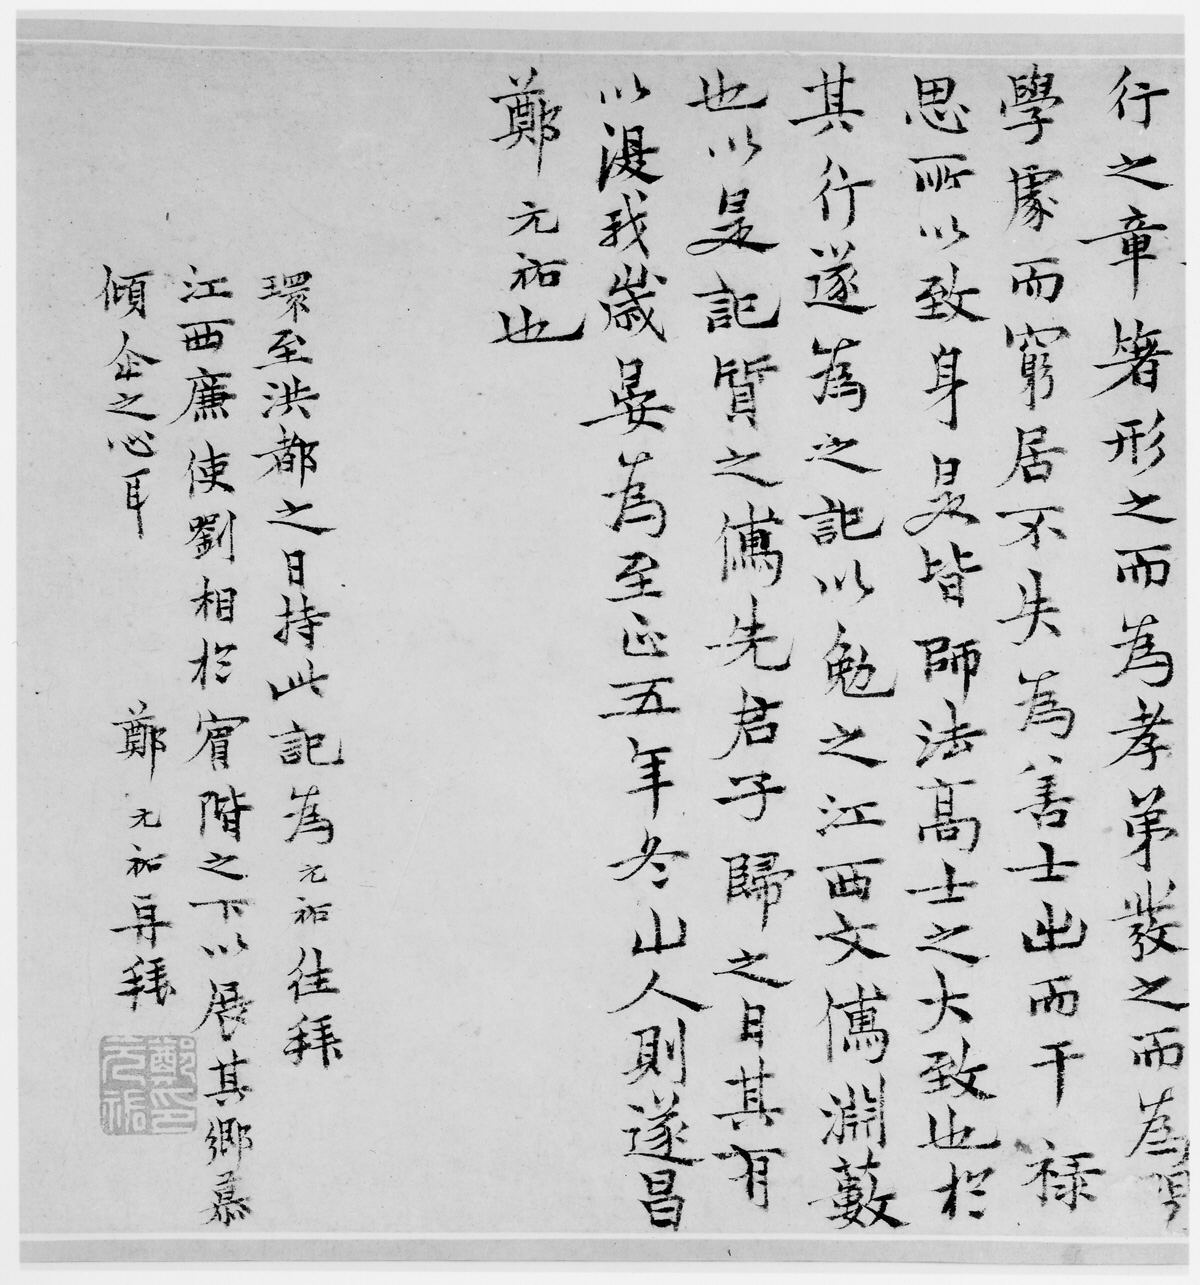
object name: handscroll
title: Record of the Following One's Ancestor Studio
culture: chinese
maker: zheng yuanyou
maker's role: artist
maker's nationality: chinese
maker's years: 1292-1364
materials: ink, paper